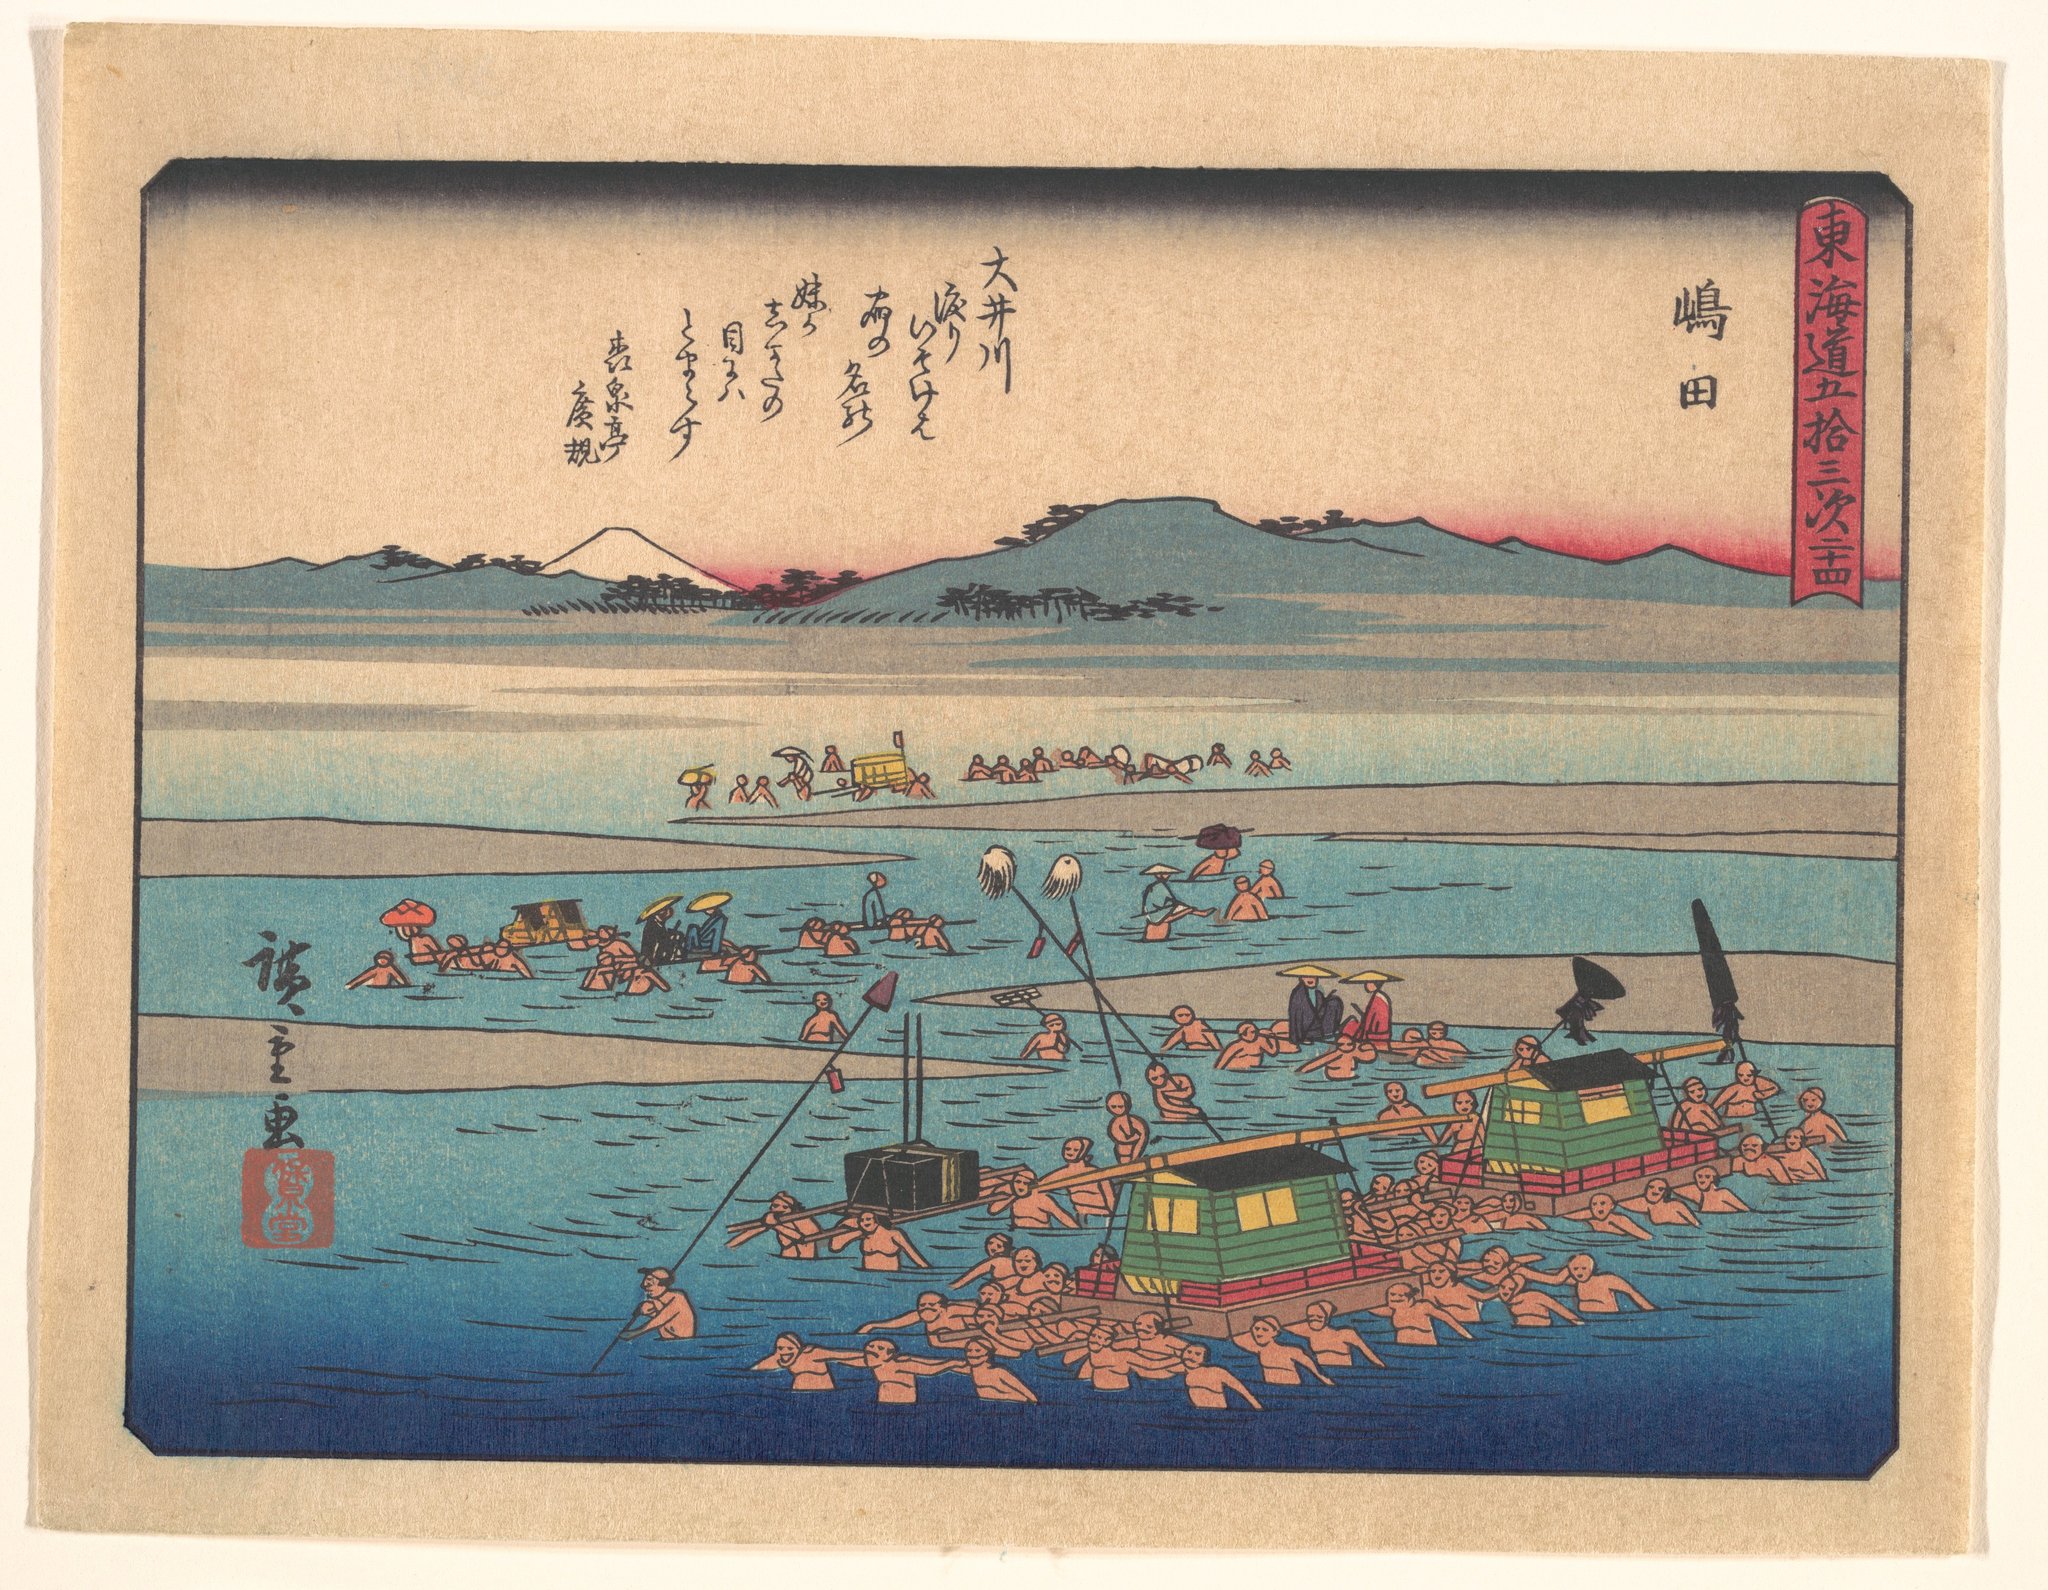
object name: print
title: 東海道五十三次之内 嶋田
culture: japanese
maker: utagawa hiroshige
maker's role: artist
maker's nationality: japanese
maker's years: 1797-1858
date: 1901-1933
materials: ink, paper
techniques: woodblock print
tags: human figures,rivers,mountains